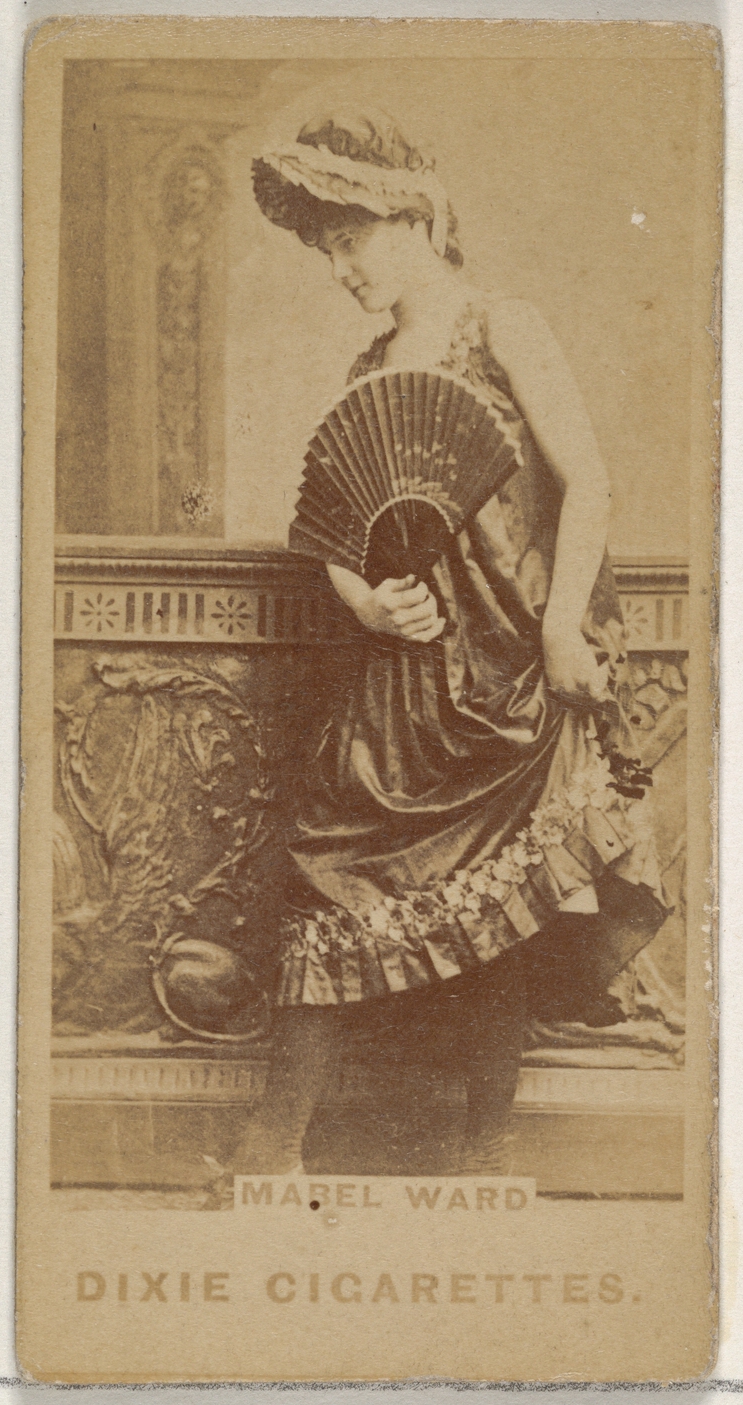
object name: photograph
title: Mabel Ward, from the Actors and Actresses series (N45, Type 7) for Dixie Cigarettes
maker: allen & ginter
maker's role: publisher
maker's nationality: american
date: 1888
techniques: albumen silver print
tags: portraits,women,actresses